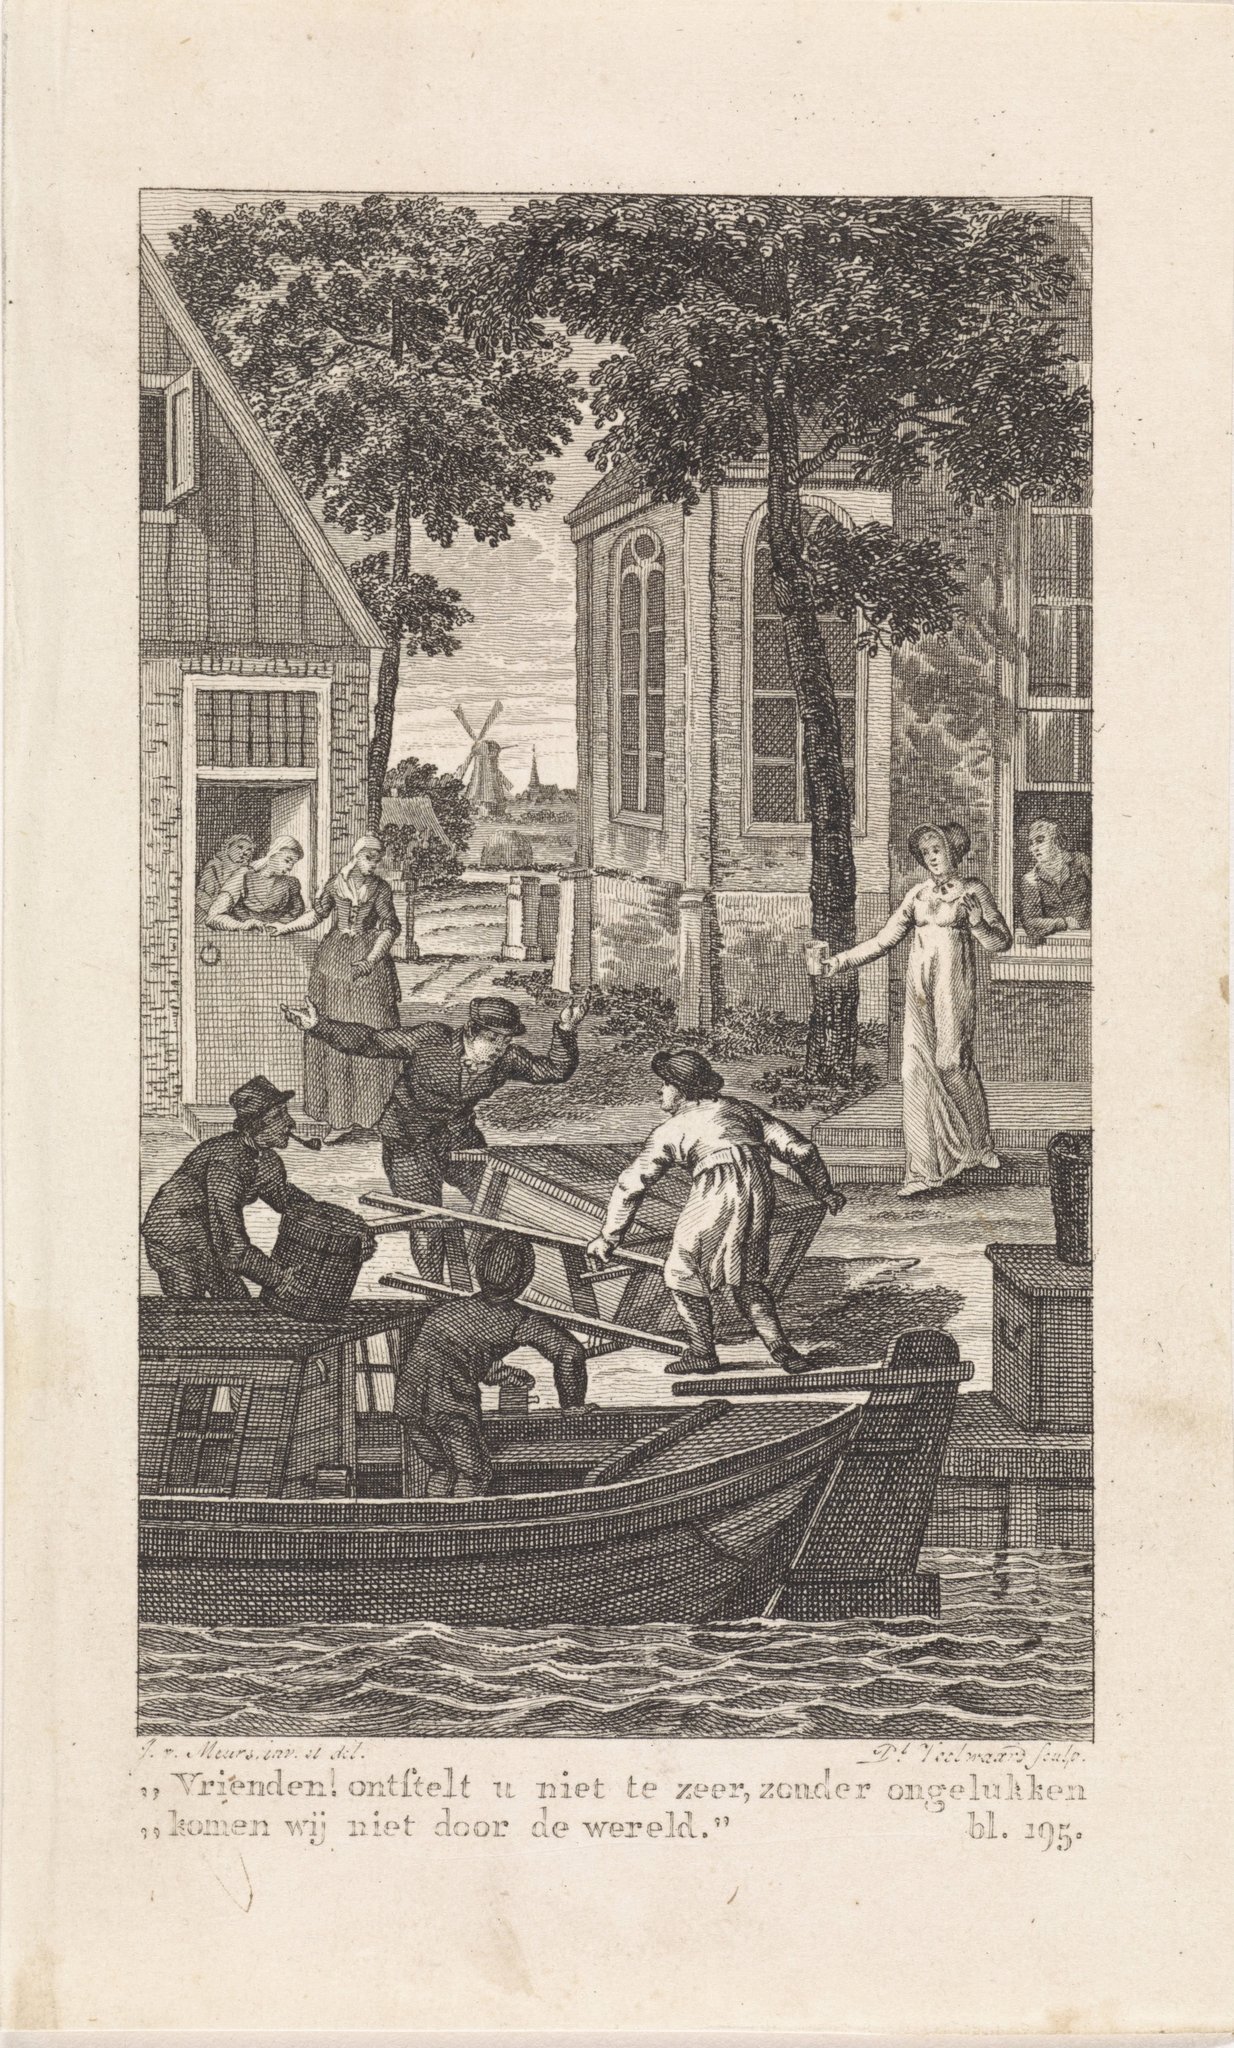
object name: book illustration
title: "Vrienden! onstelt u niet te zeer, zonder ongelukken komen wij niet door de wereld"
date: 1823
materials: paper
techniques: etching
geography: amsterdam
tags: cupboard, quay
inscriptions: collector's mark: Lugt 2760, collector's mark: Lugt 2228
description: Prent gebruikt als boekillustratie in: Hazeu Cornelisz., Johannes. De geschiedenis van Laura Guldenbeek: Een onderhoudend en leerzaam leesboek voor jonge lieden. Amsterdam: M.H. Helmig, 1823.